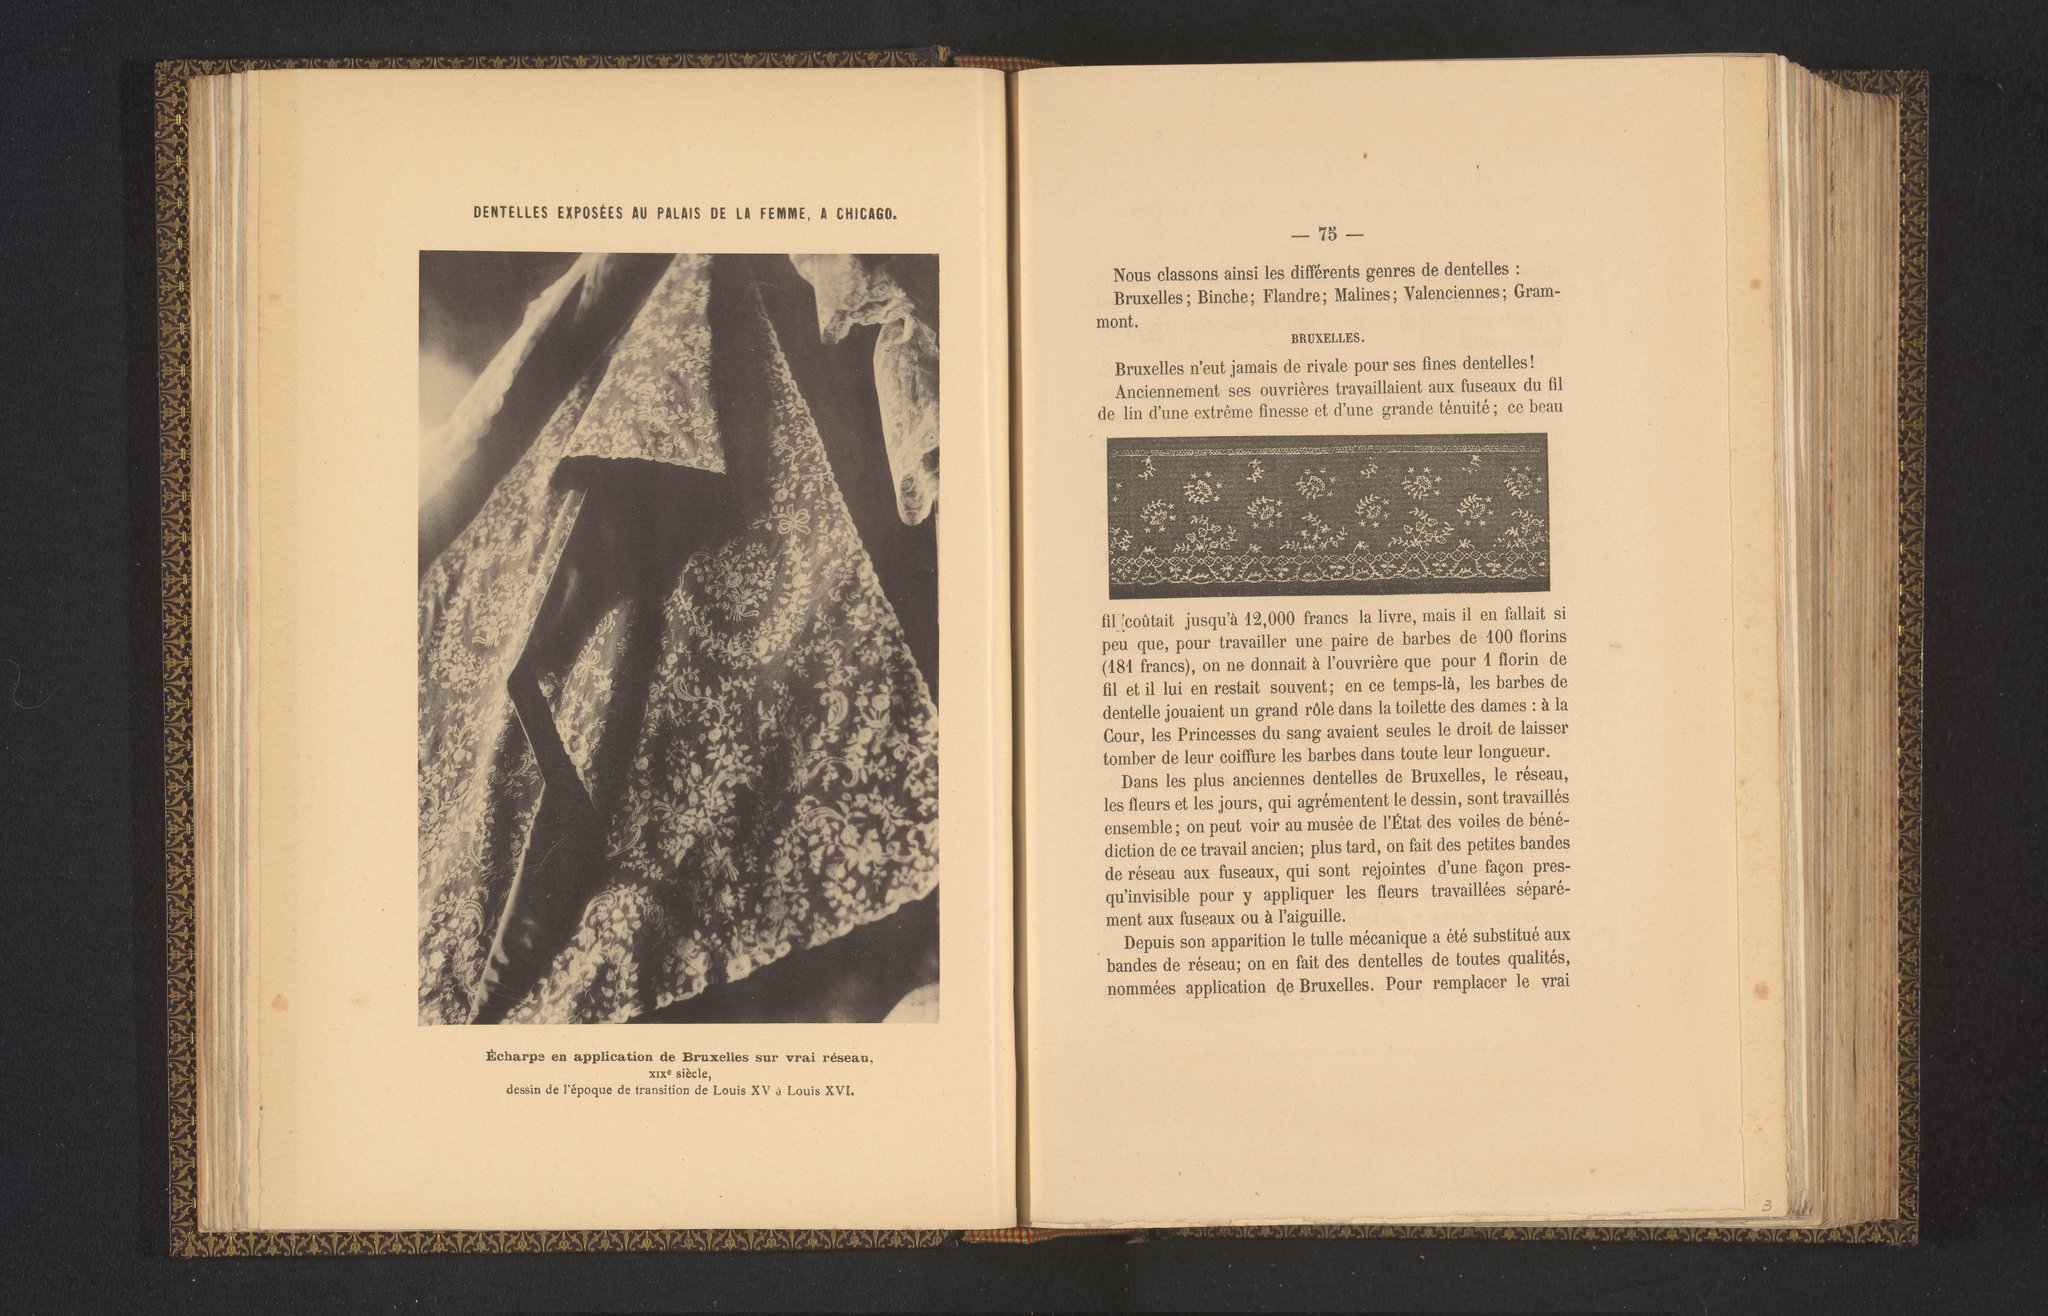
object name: photomechanical print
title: Écharps en application de Bruxelles sur vrai réseau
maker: Anonymous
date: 1888-1893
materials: paper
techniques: photograph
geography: chicago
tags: accessories (~ clothing)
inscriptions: inscription: ‘XIXe siècle,/ dessin de l'époque de transition de Louis XV à Louis XVI.’